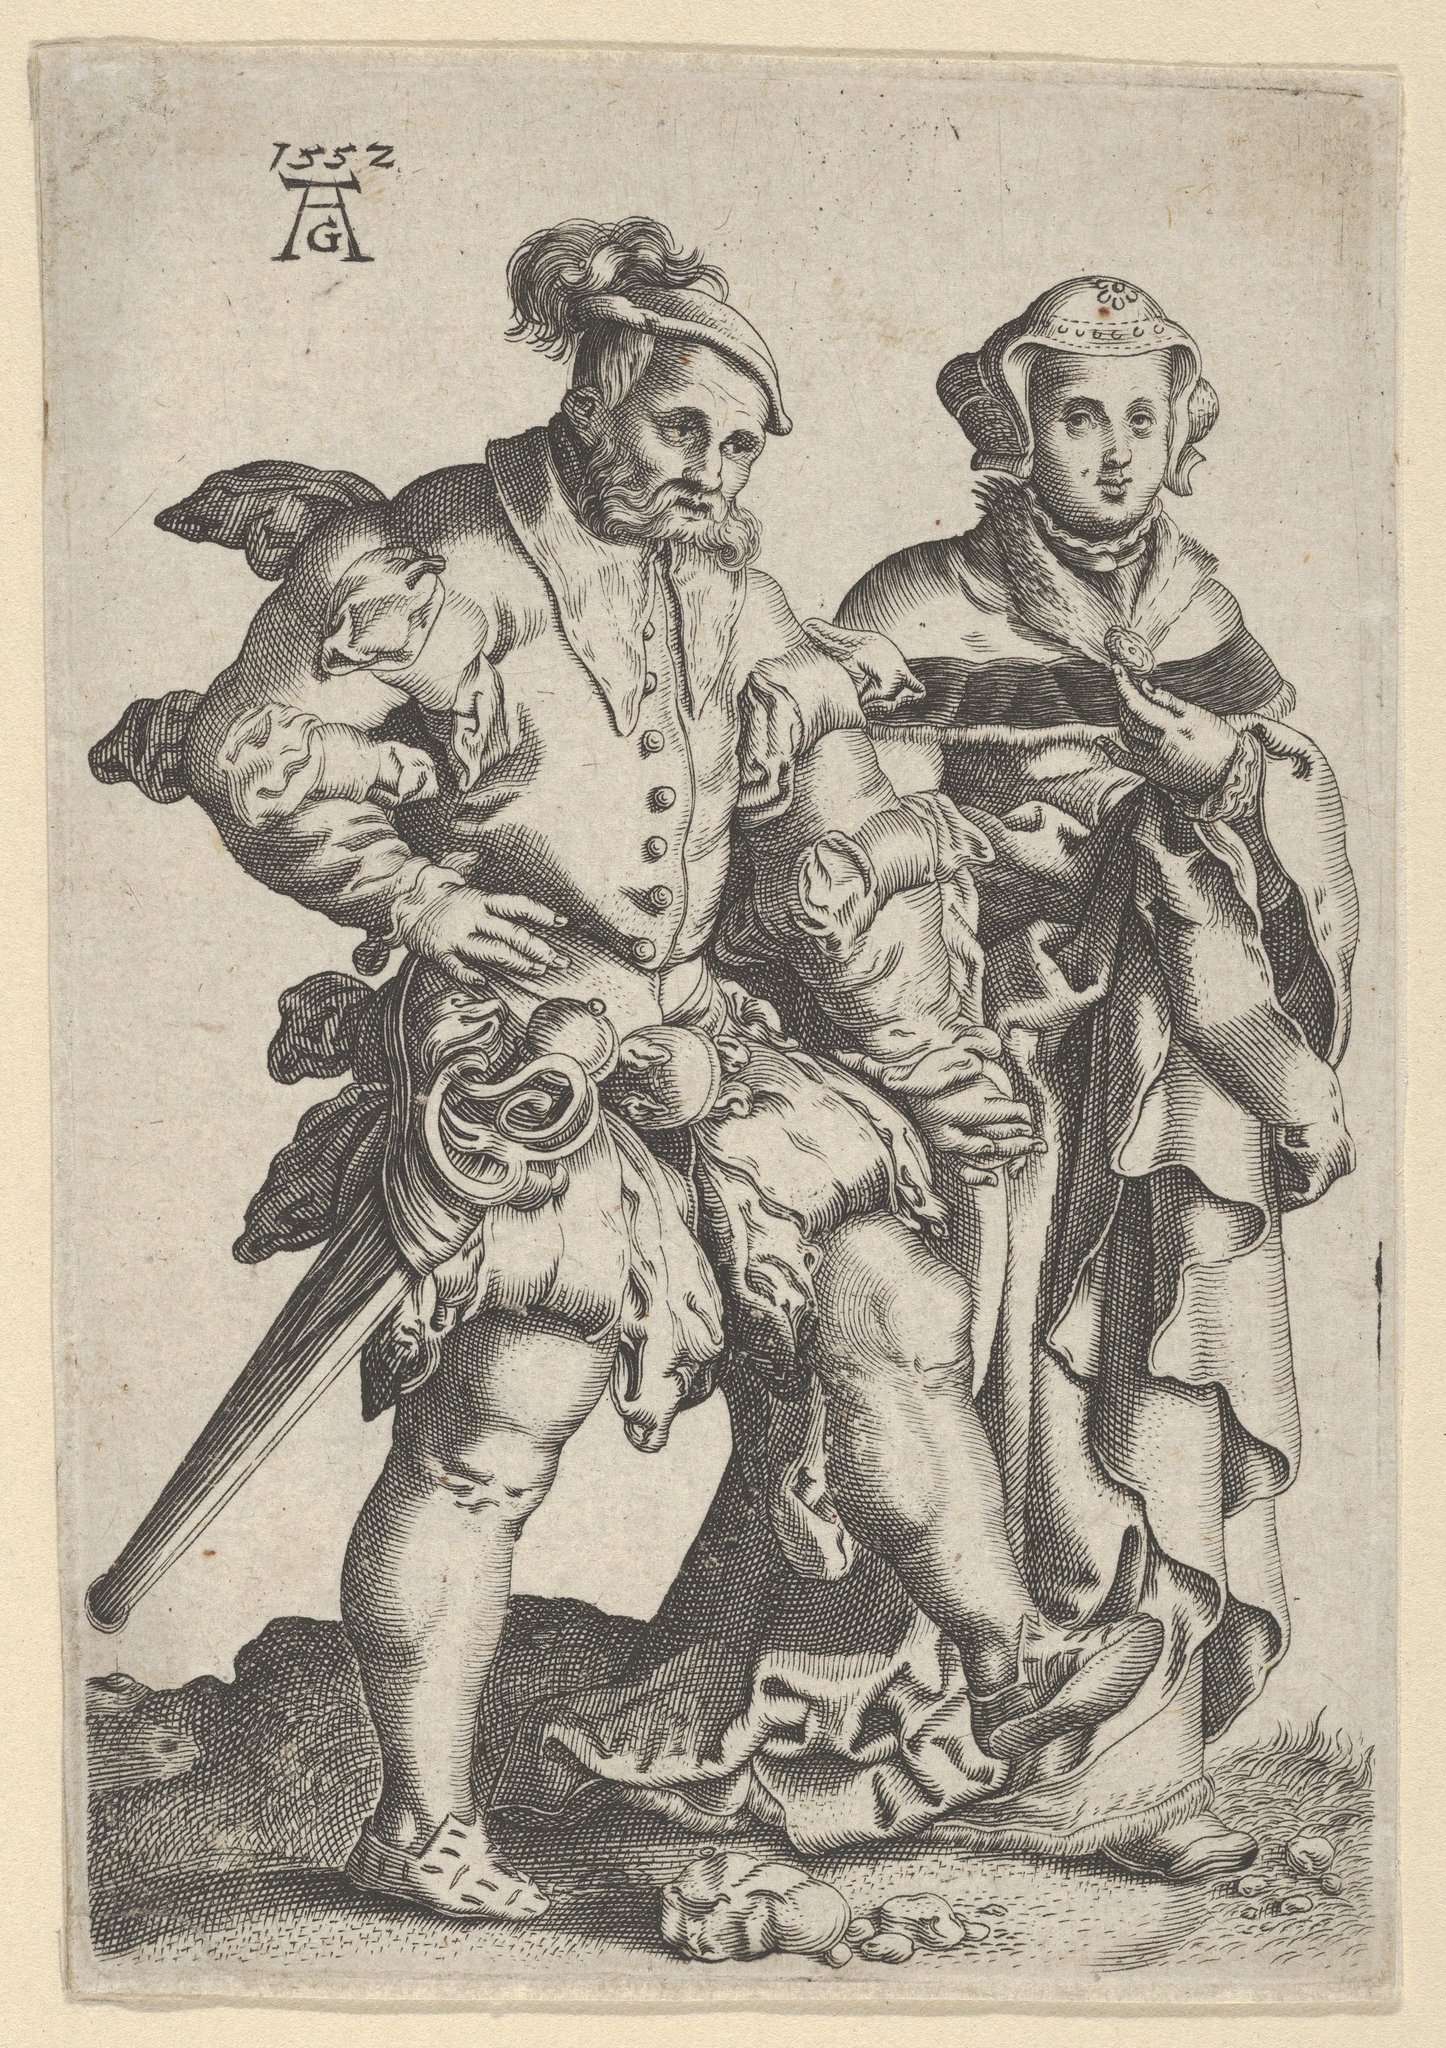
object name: print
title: Reverse Copy of Dancing Couple, from "The Small Wedding Dancers"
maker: anonymous, german, 16th century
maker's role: artist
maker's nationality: german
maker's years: 1500-1600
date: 1552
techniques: engraving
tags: couples,men,women,dancing